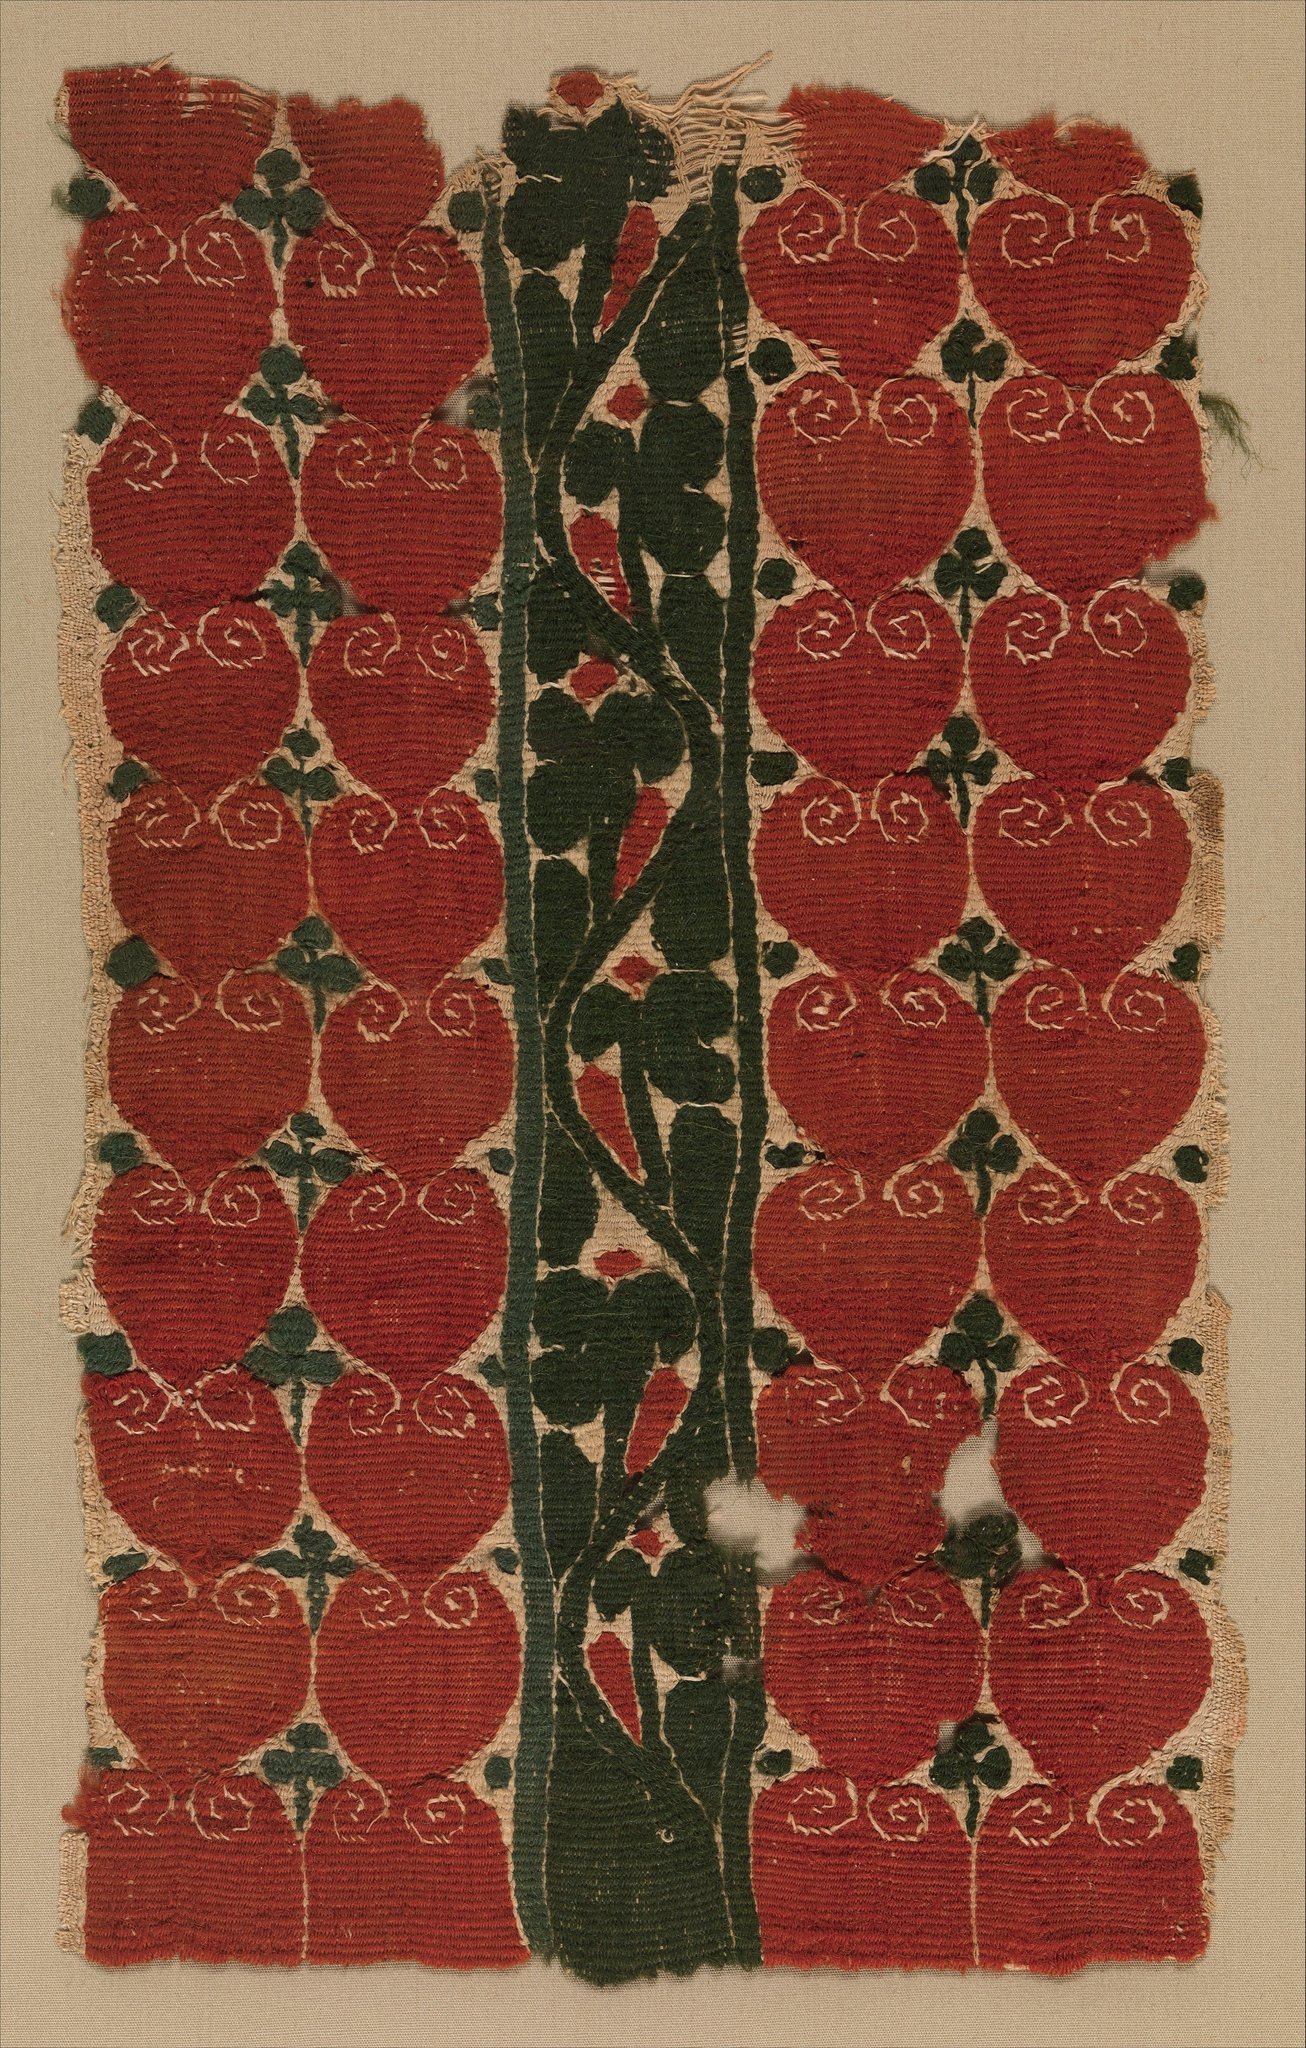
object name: textile fragment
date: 301-500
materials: linen, wool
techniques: weave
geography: egypt